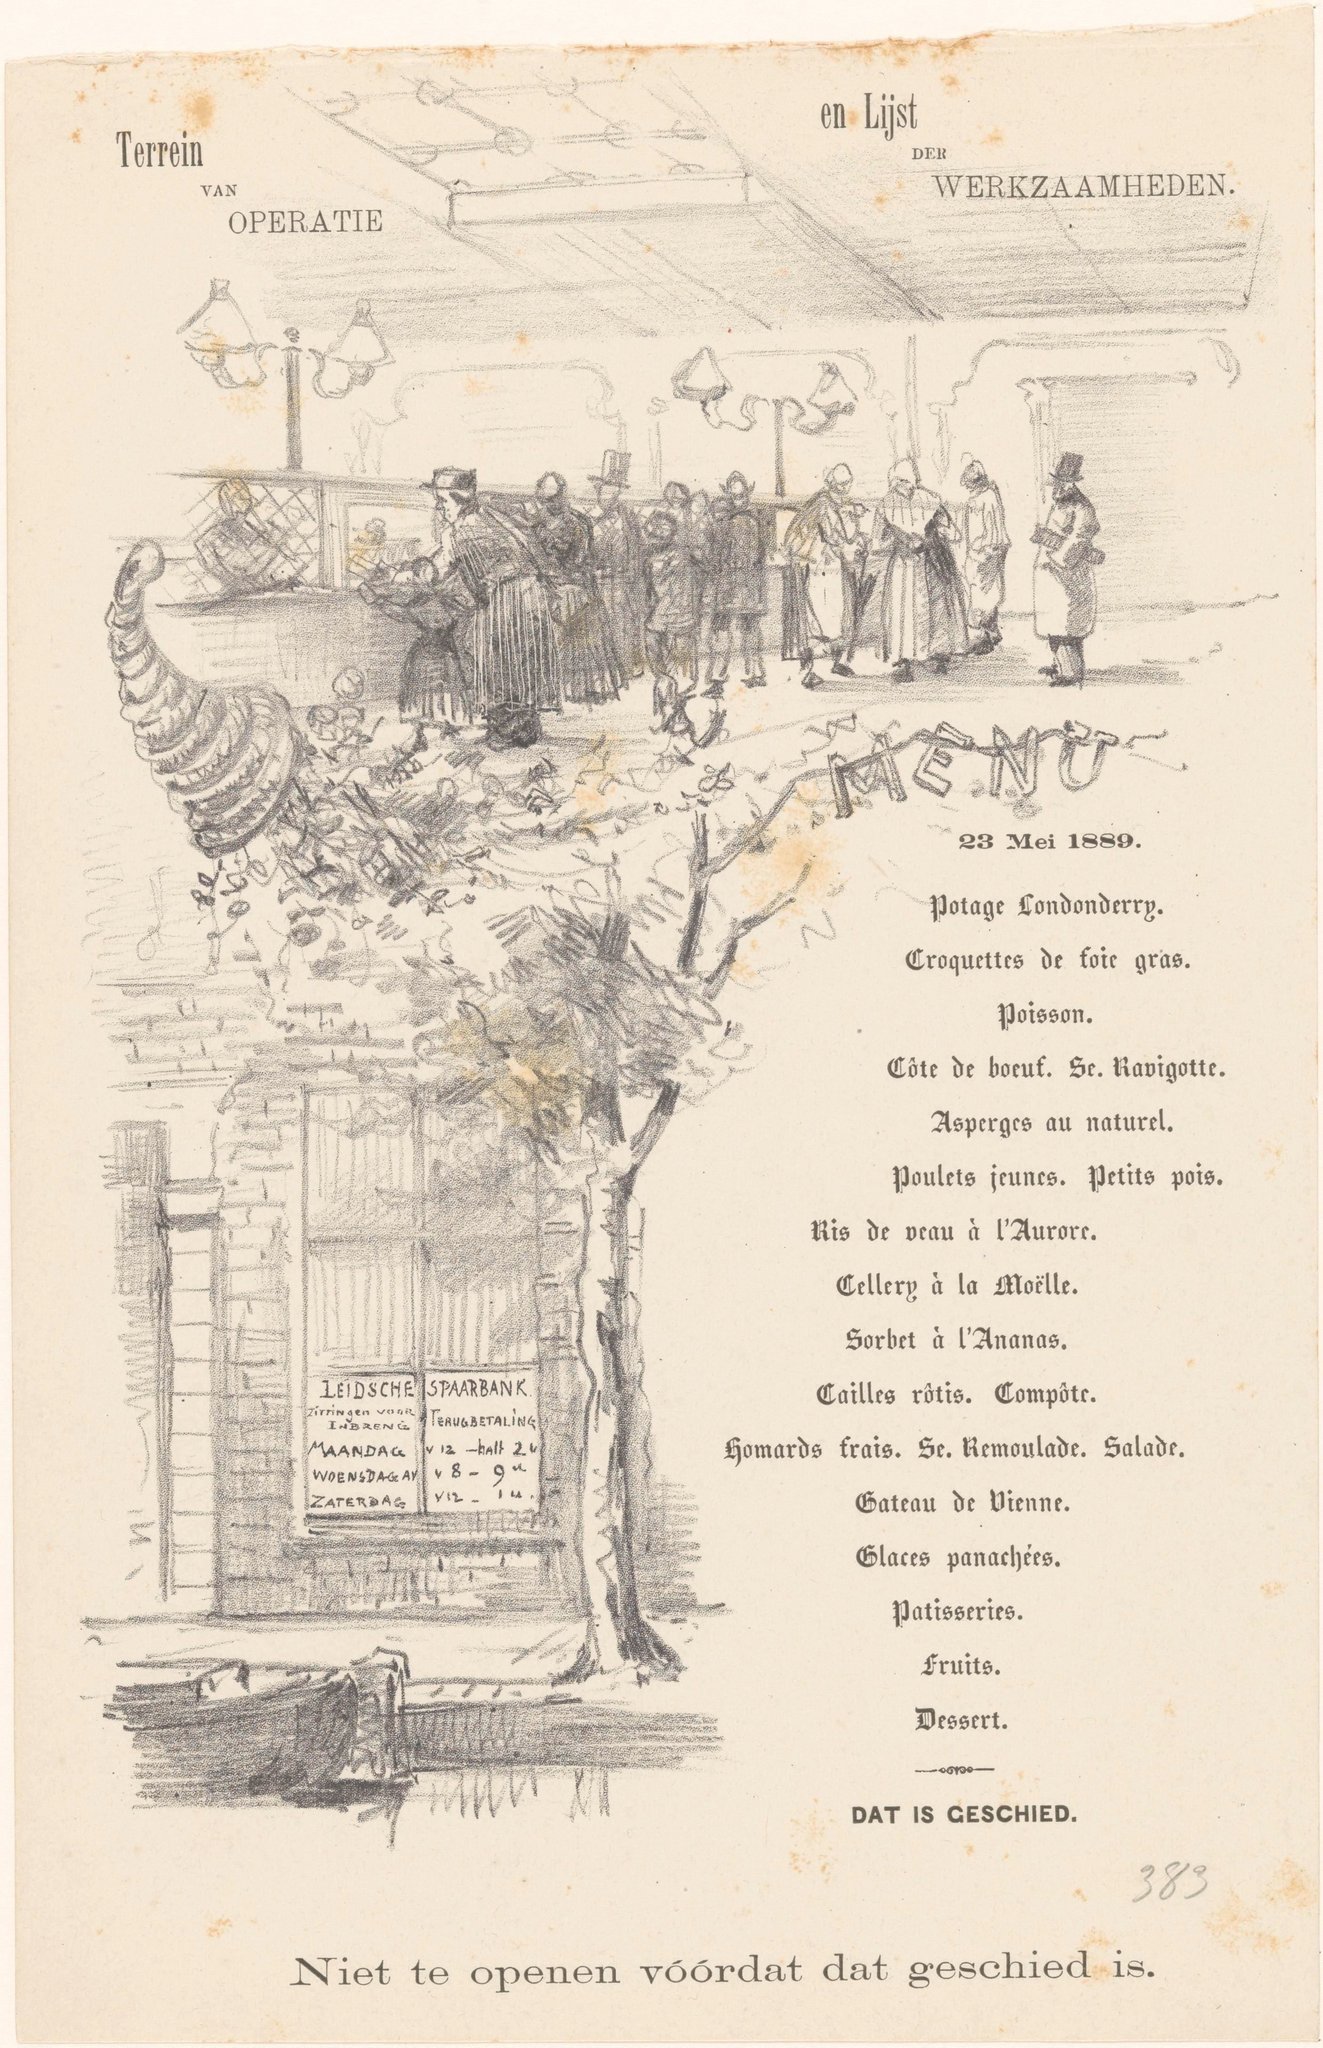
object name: menu, menukaart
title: Menukaart voor de Leidsche spaarbank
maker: theo van hoytema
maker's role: draughtsman, painter, print maker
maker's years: 1863-1917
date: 1805-1889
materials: paper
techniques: letterpress printing, lithograph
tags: 'cornucopia', horn of plenty, bank, leiden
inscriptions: number: ‘383’, collector's mark: Lugt 2228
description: Bovenaan staan mensen bij loketten. Rechts het woord menu en een lijst met gerechten. Linksonder een venster met het opschrift 'Leidsche Spaarbank'.